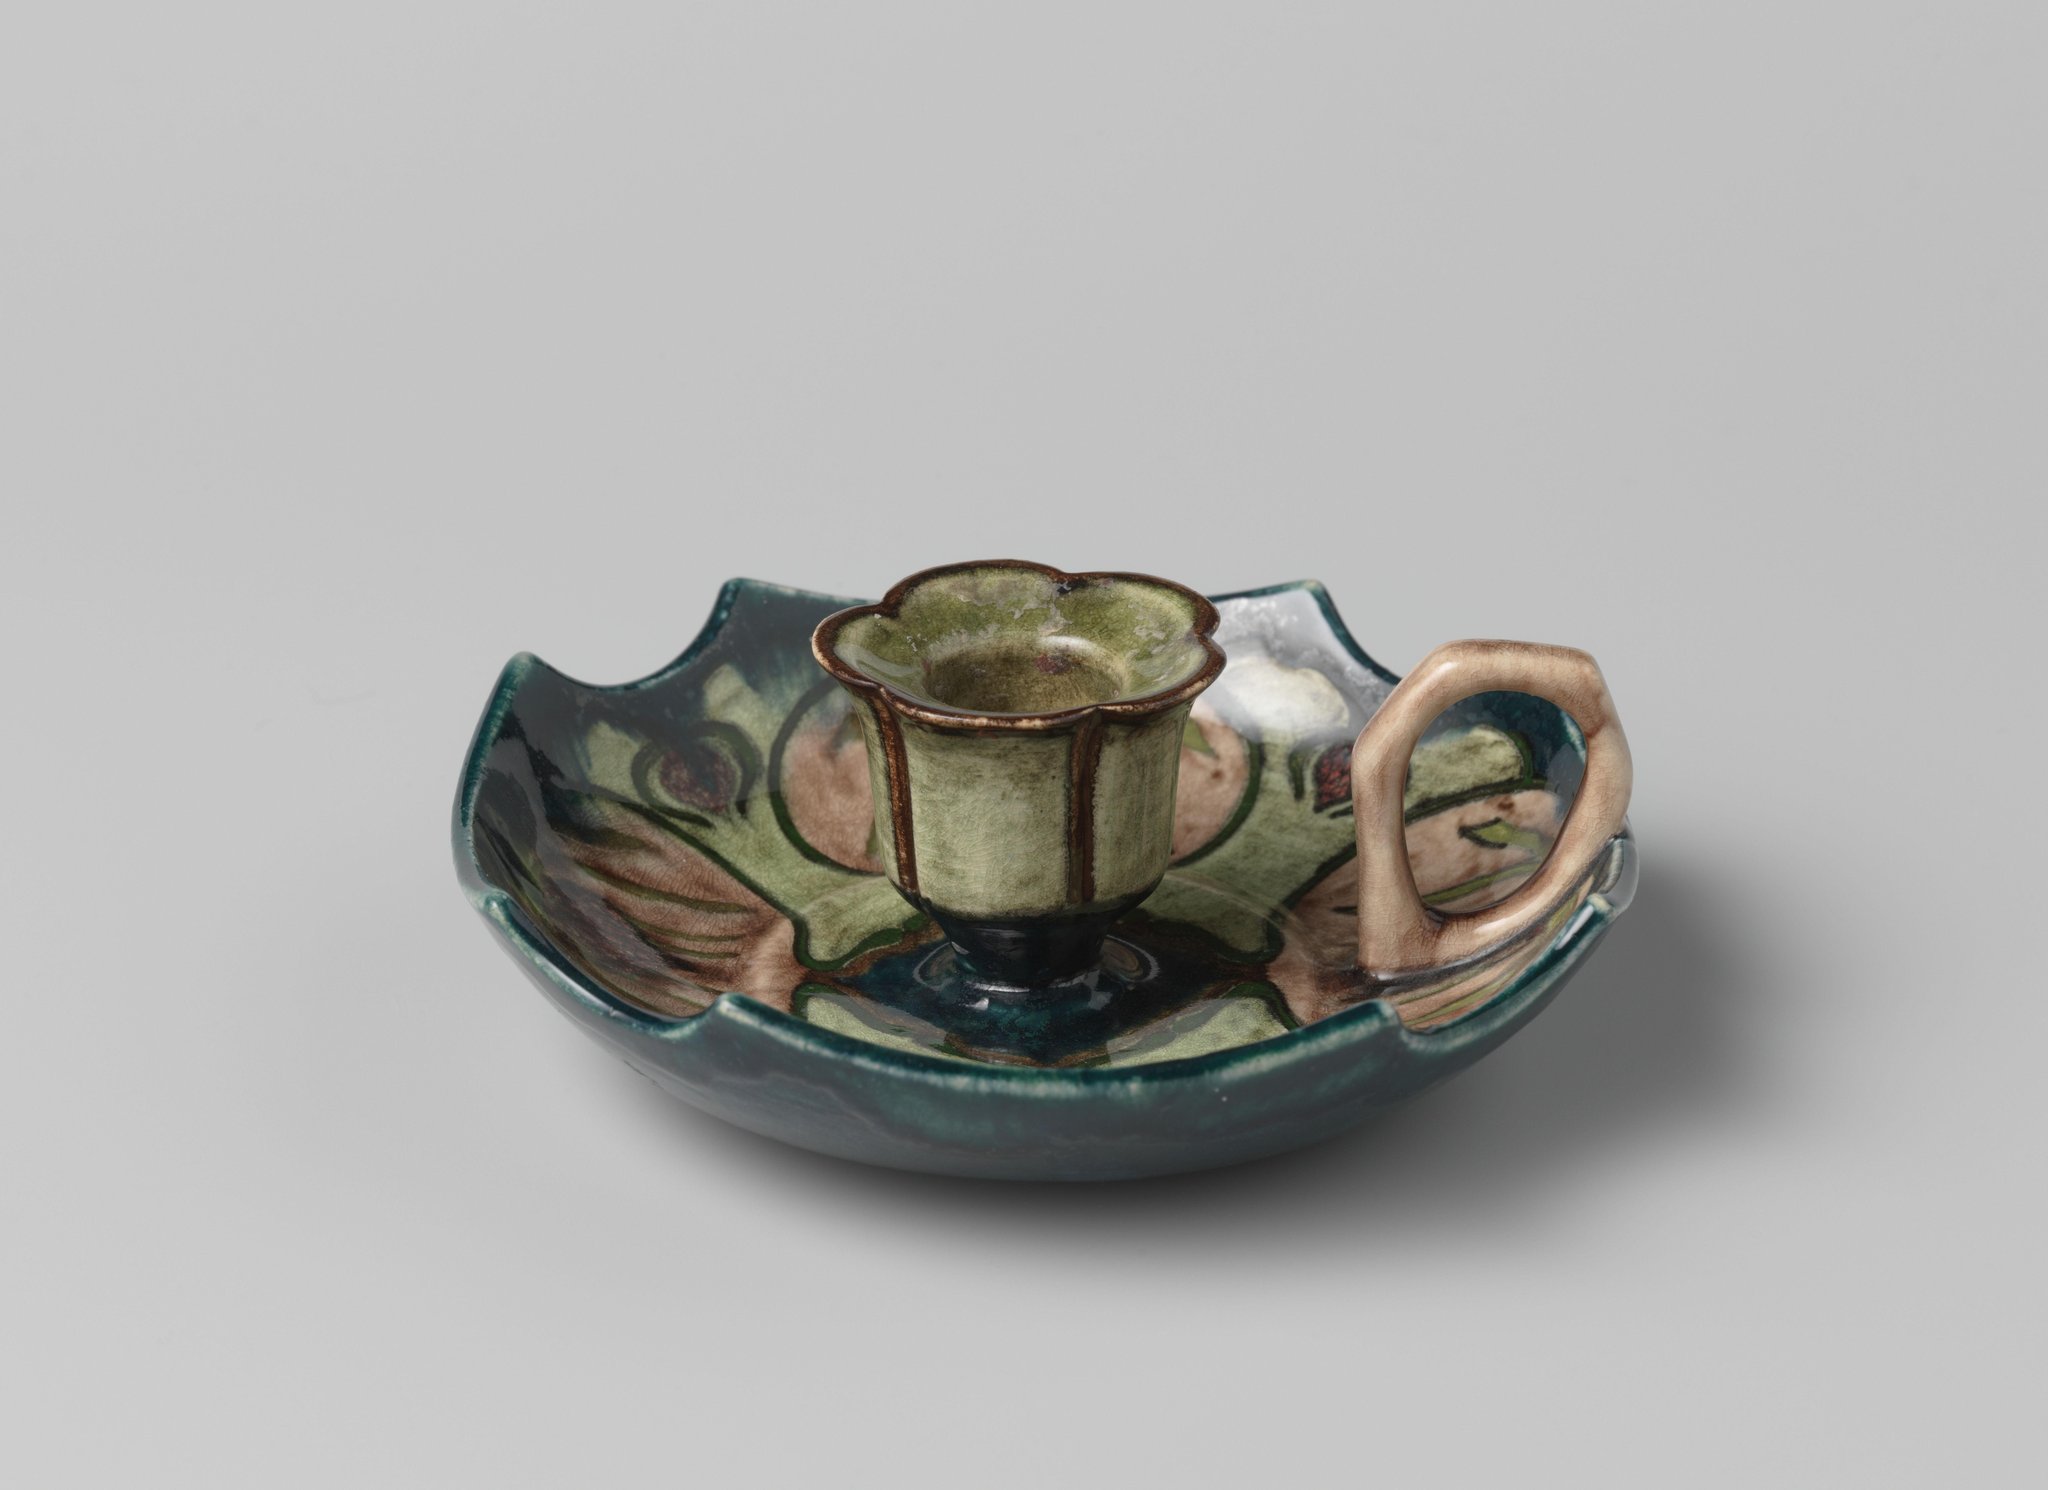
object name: chamberstick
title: Blaker met oor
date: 1895-1904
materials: earthenware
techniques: painted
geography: purmerend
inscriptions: mark: ‘klomp // monogram (NB.) // Faïence // de // Purmerende // Hollande // 1115. Dec:A // monogram HD.G.’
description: Blaker, vierkant met naar binnen afgeronde hoeken en een oor. Kaarshouder in vorm van bloem. Polychrome beschildering van bloemknoppen.